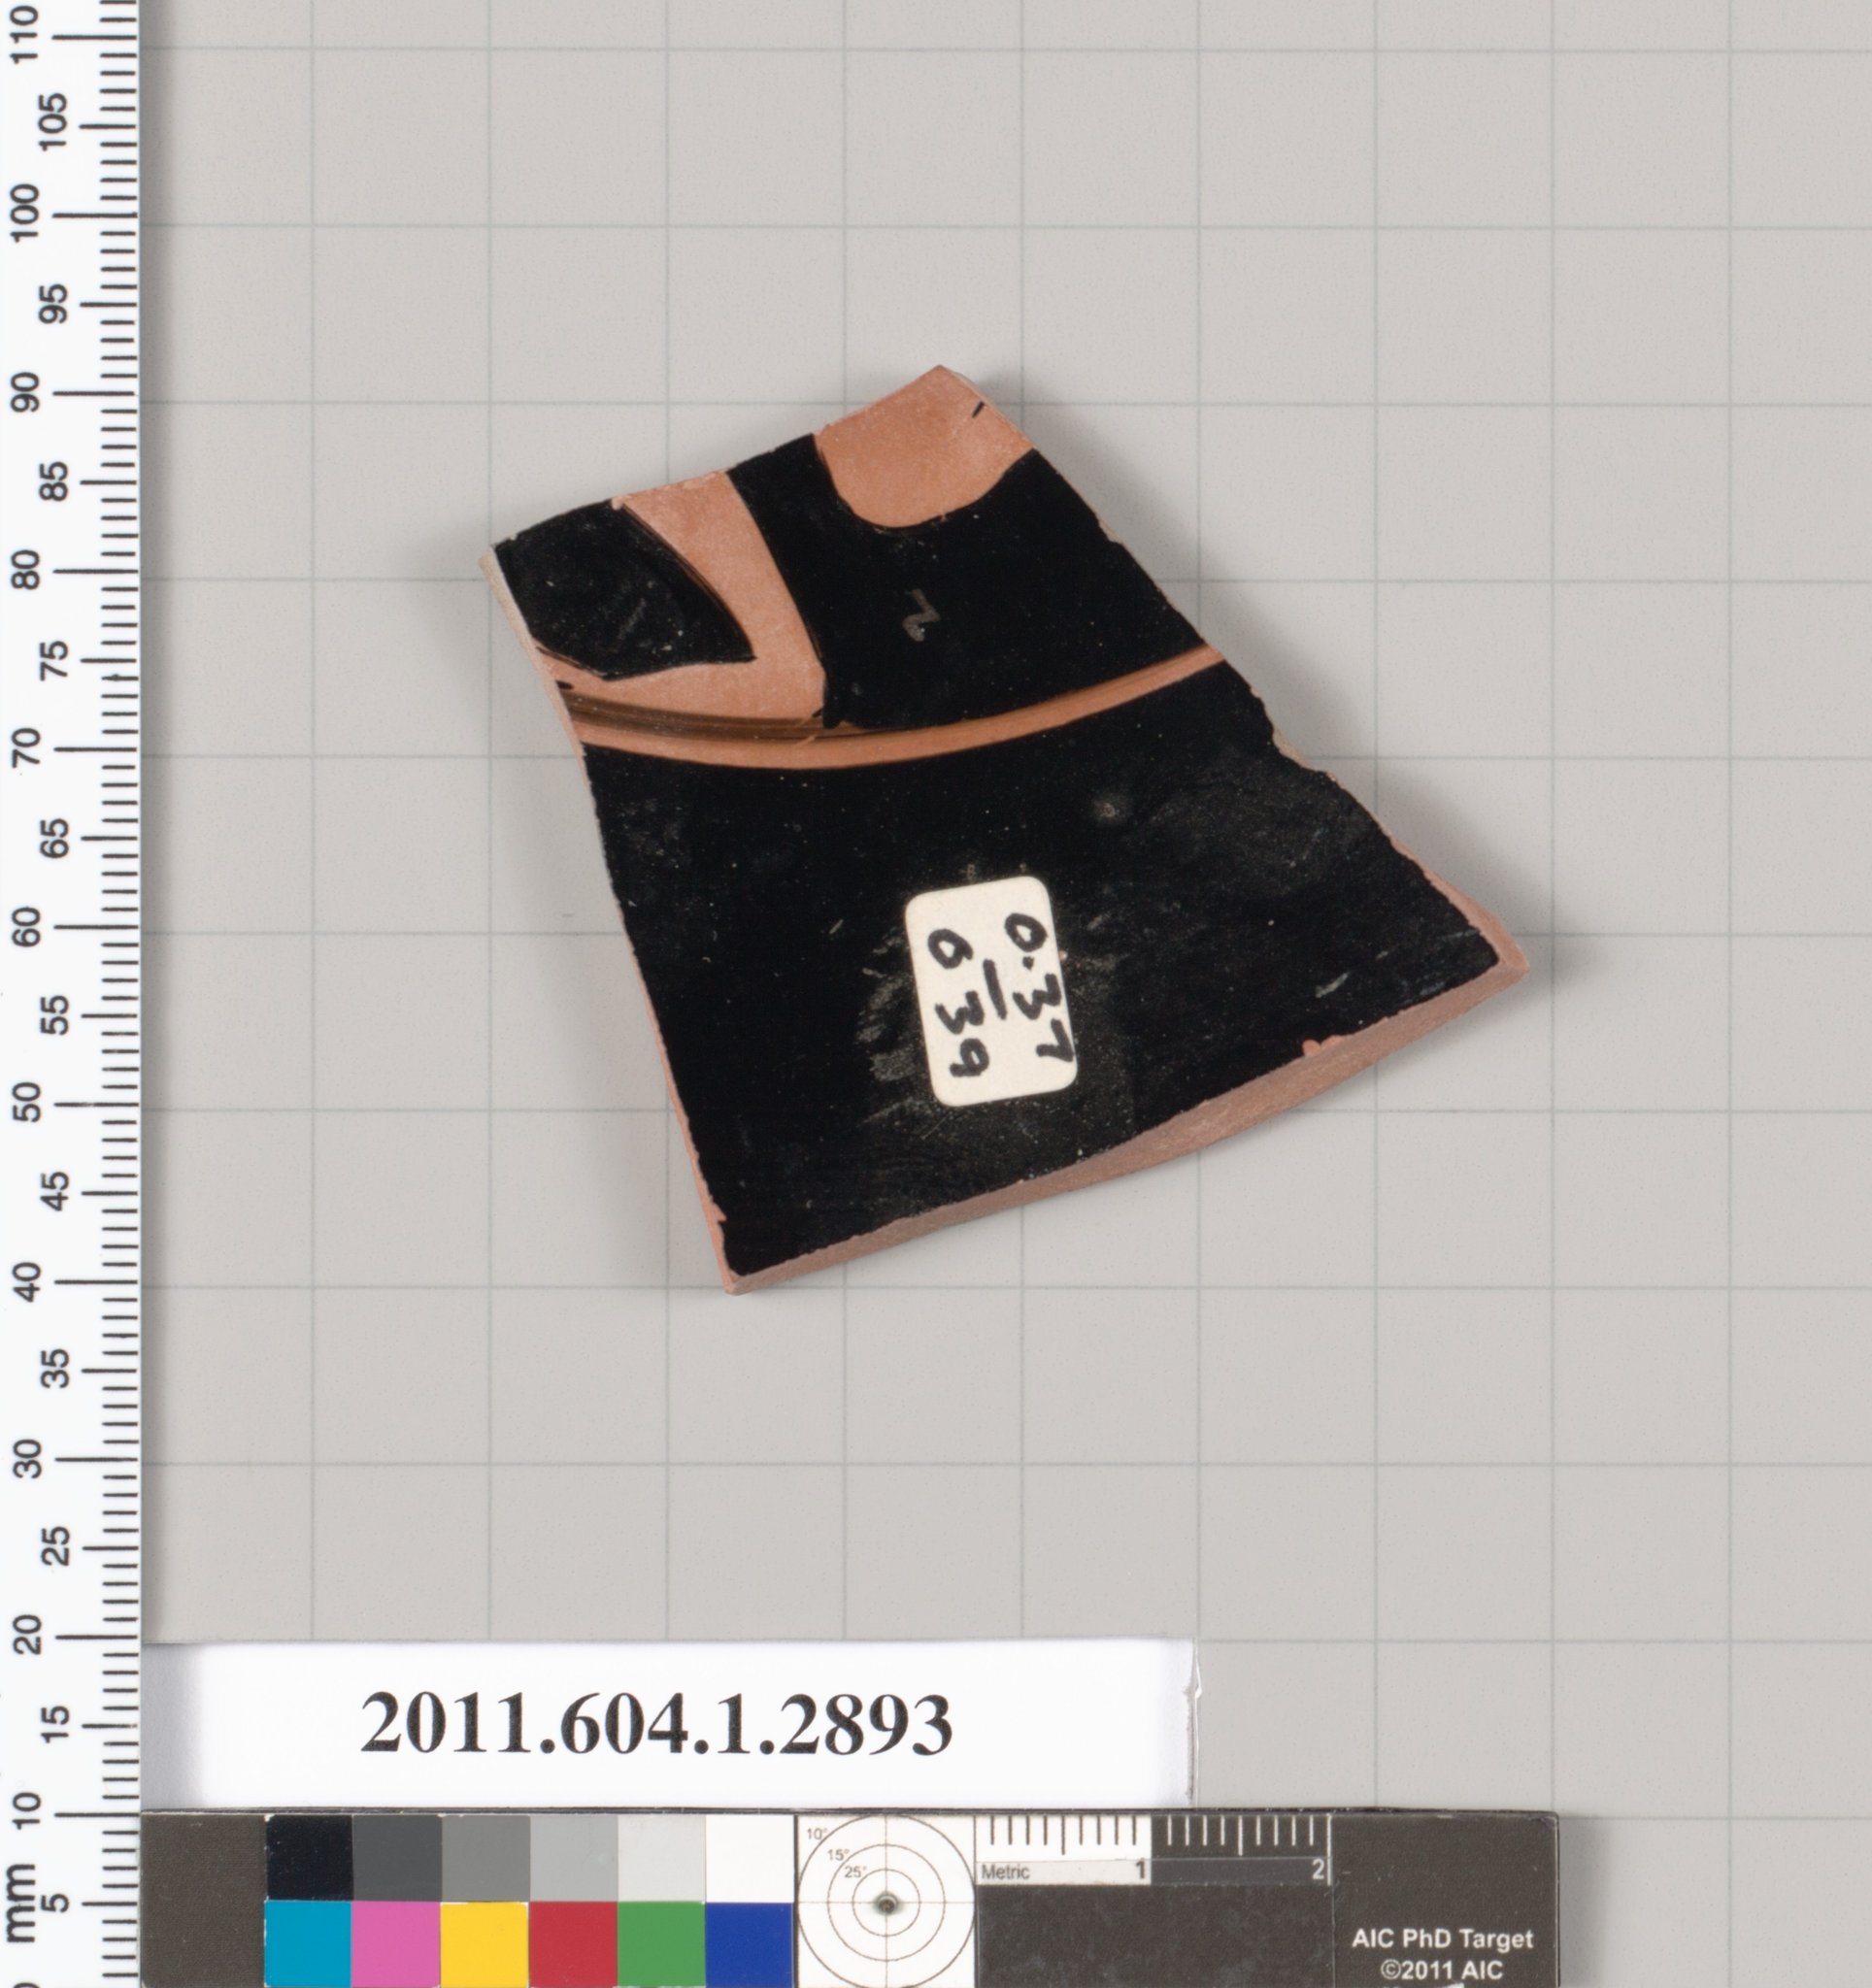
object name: kylix fragment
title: Terracotta fragment of a kylix (drinking cup)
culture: greek, attic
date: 520-500 BCE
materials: terracotta